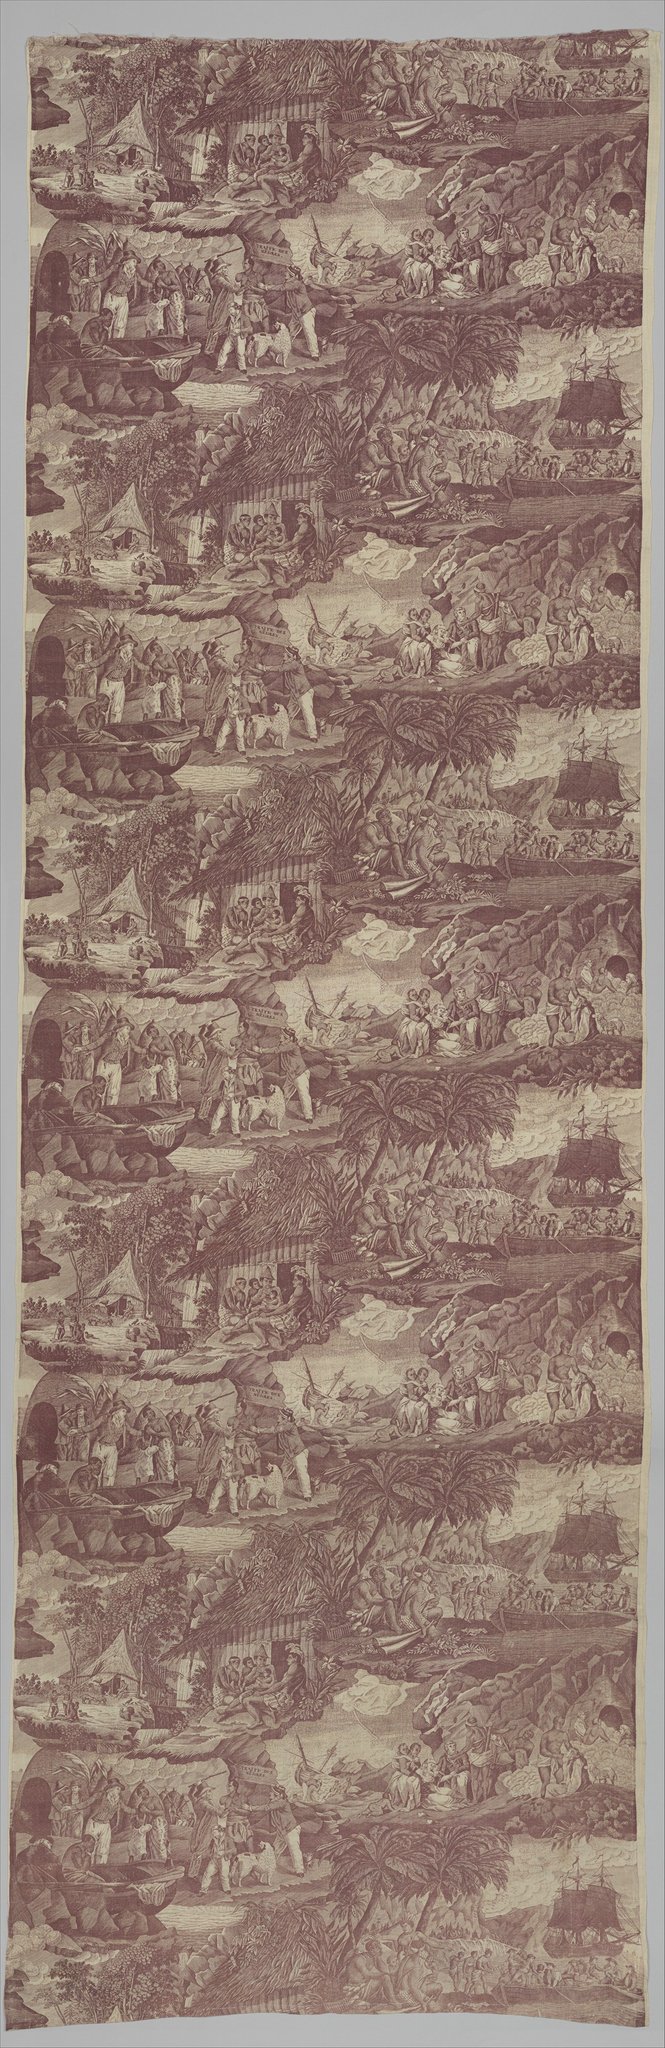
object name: furnishing textile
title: Traite des Nègres (The Slave Trade)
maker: frédéric etienne joseph feldtrappe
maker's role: designer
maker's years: 1746-1849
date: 1801-1833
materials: cotton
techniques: printing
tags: animals,houses,men,women